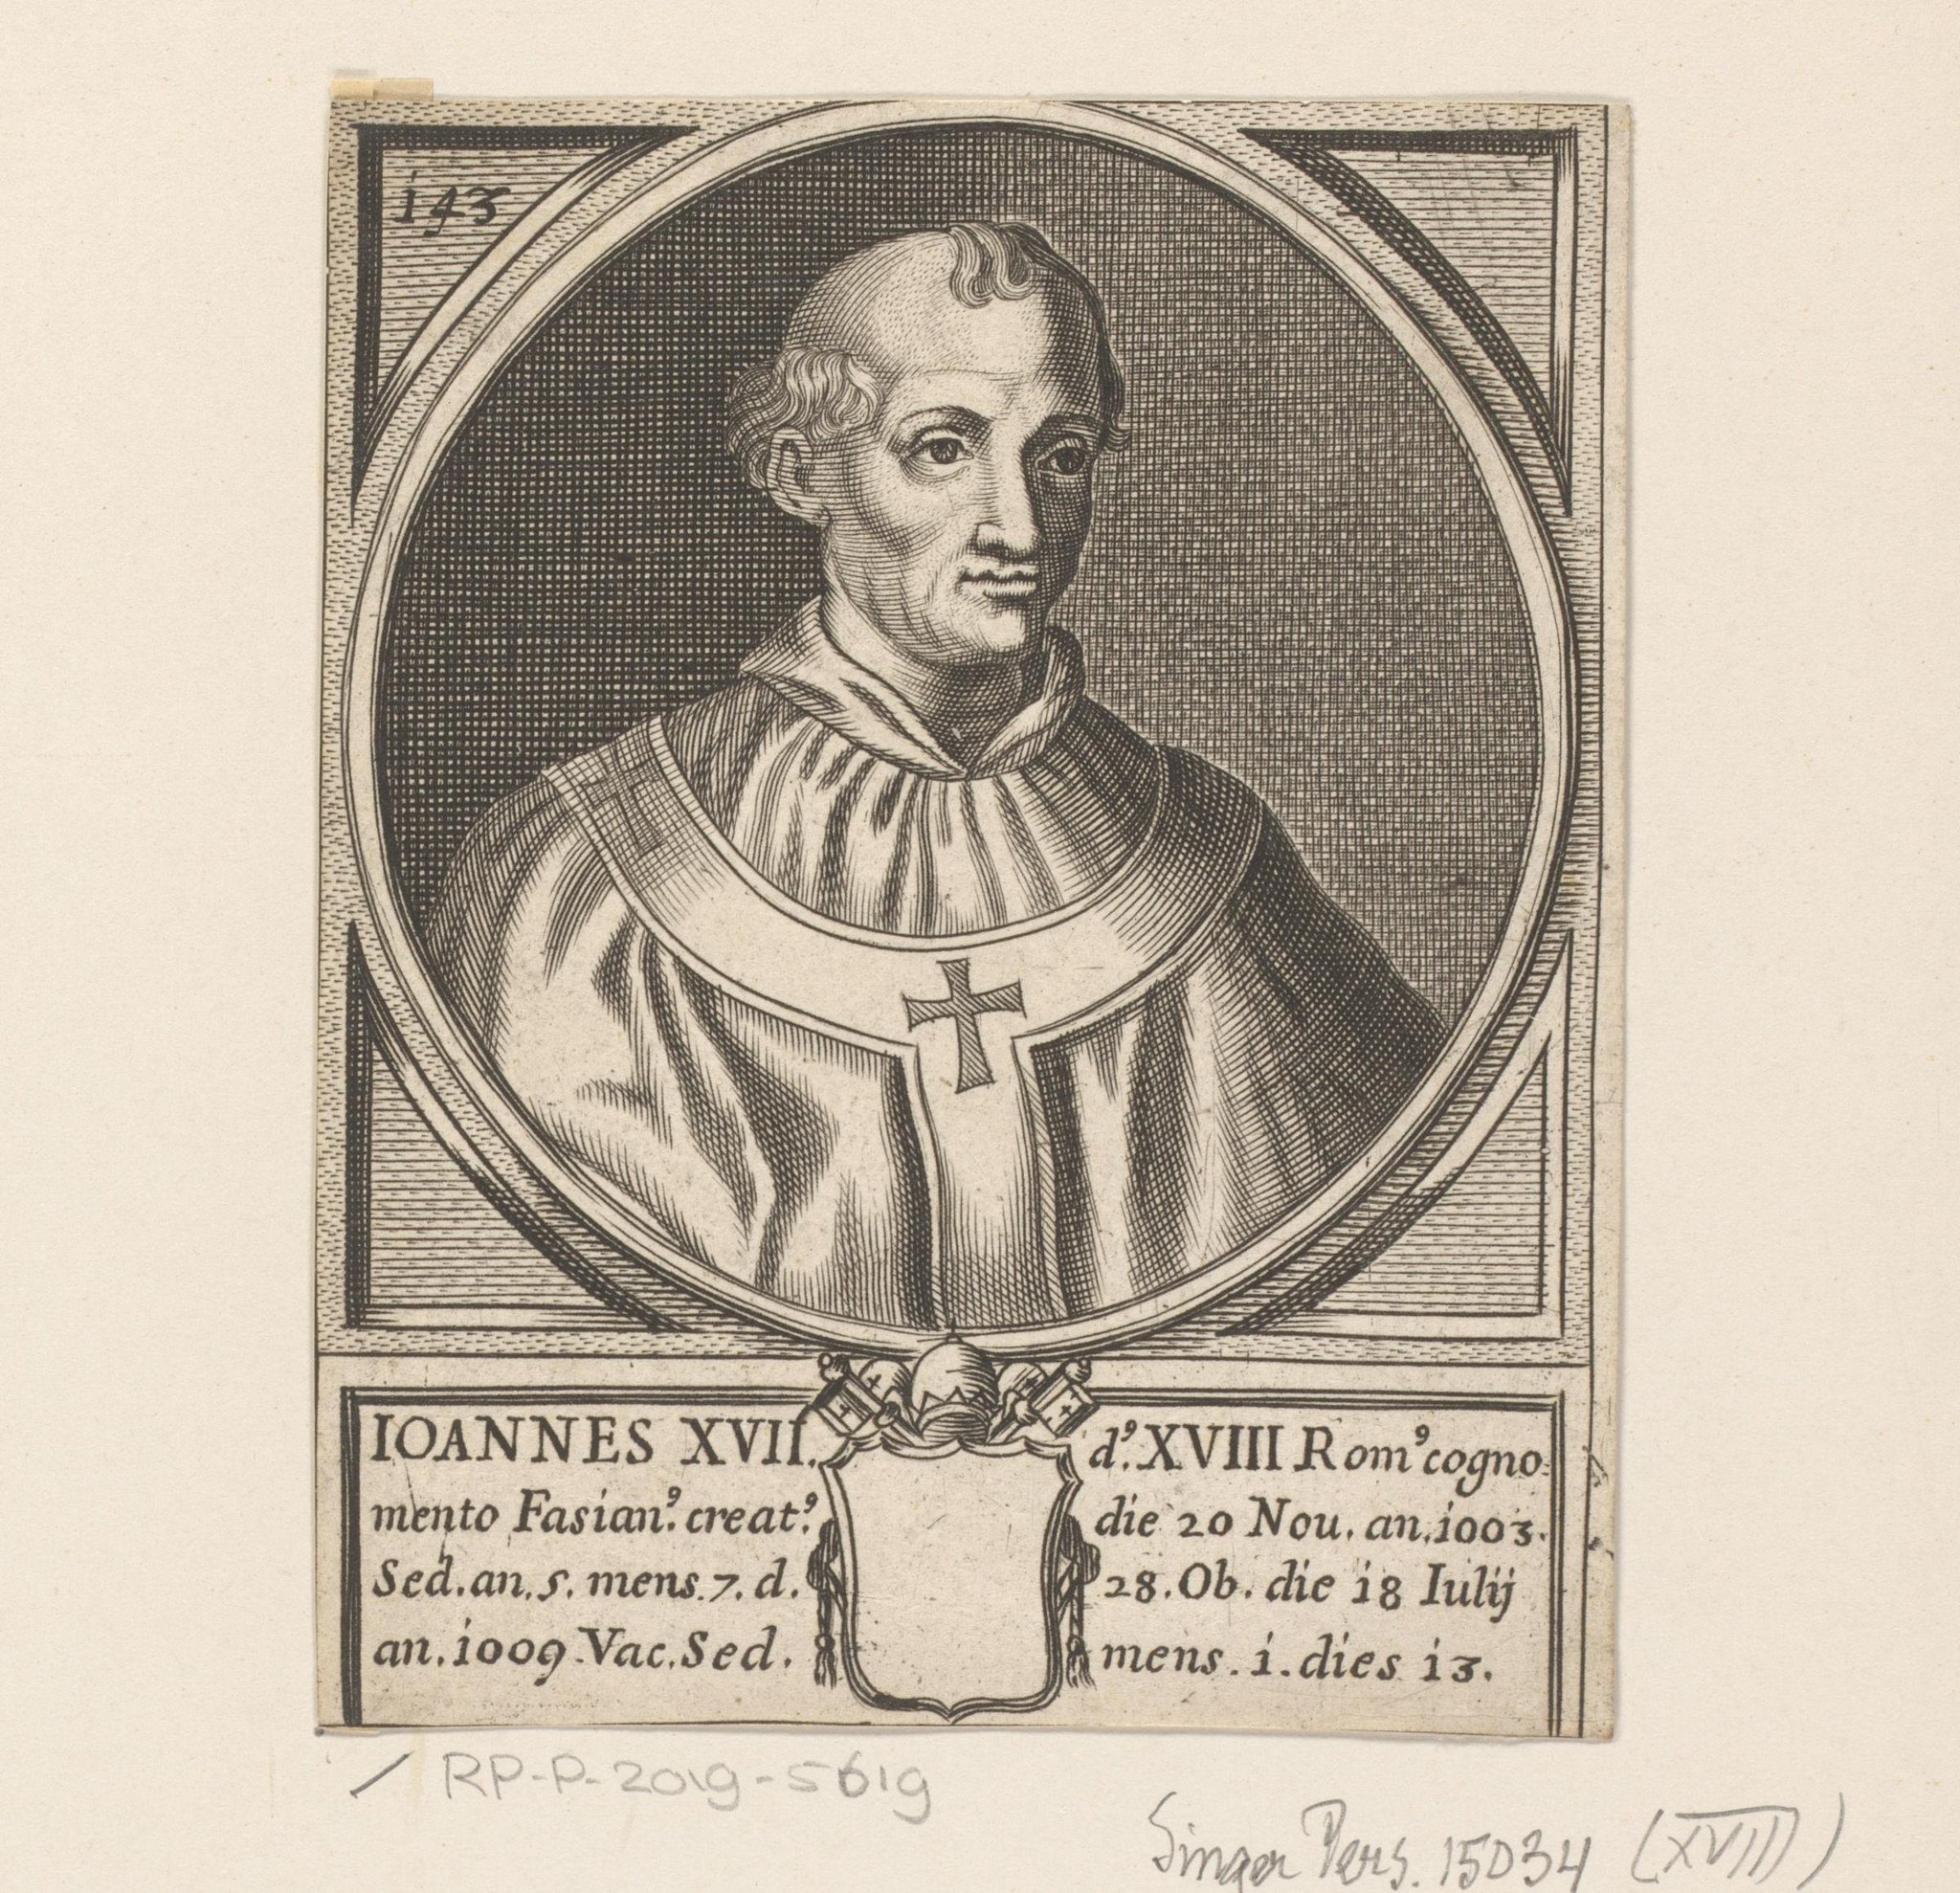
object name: print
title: Chronologische portretten van pausen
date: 1675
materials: paper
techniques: engraving, etching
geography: rome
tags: rome, historical persons, pope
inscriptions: inscription: ‘4’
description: Portret afkomstig uit een grote prent, bestaande uit 17 bladen die samengevoegd konden worden, uitgegeven door Giovanni Giacomo de' Rossi in 1675.